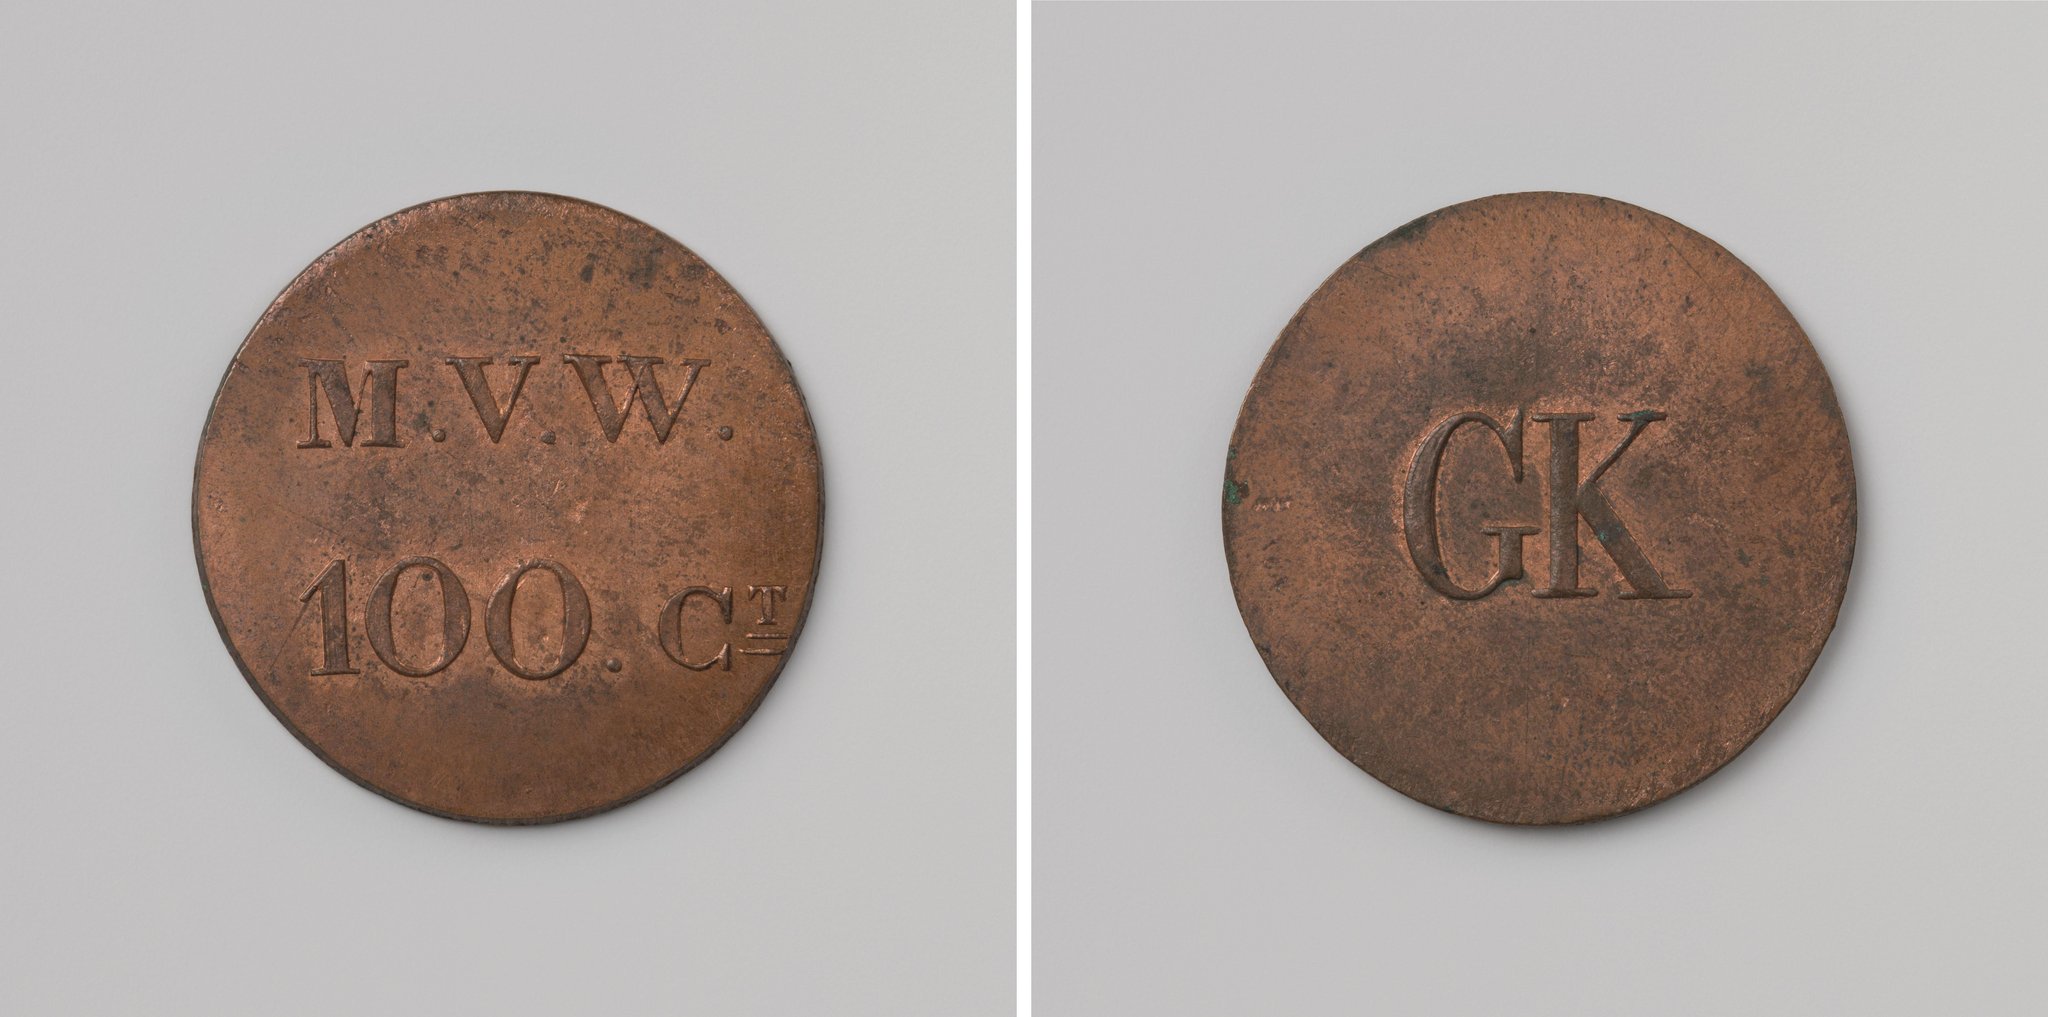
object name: honderd cent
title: Huismunt geslagen op last van de Maatschappij van Weldadigheid ter waarde van 1 gulden, ten behoeve van de Gewone Koloniën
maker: Anonymous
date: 1818-1859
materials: copper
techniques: striking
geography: netherlands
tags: maatschappij van weldadigheid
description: Voorzijde: opschrift boven waardeaanduiding. Keerzijde: letters G en K